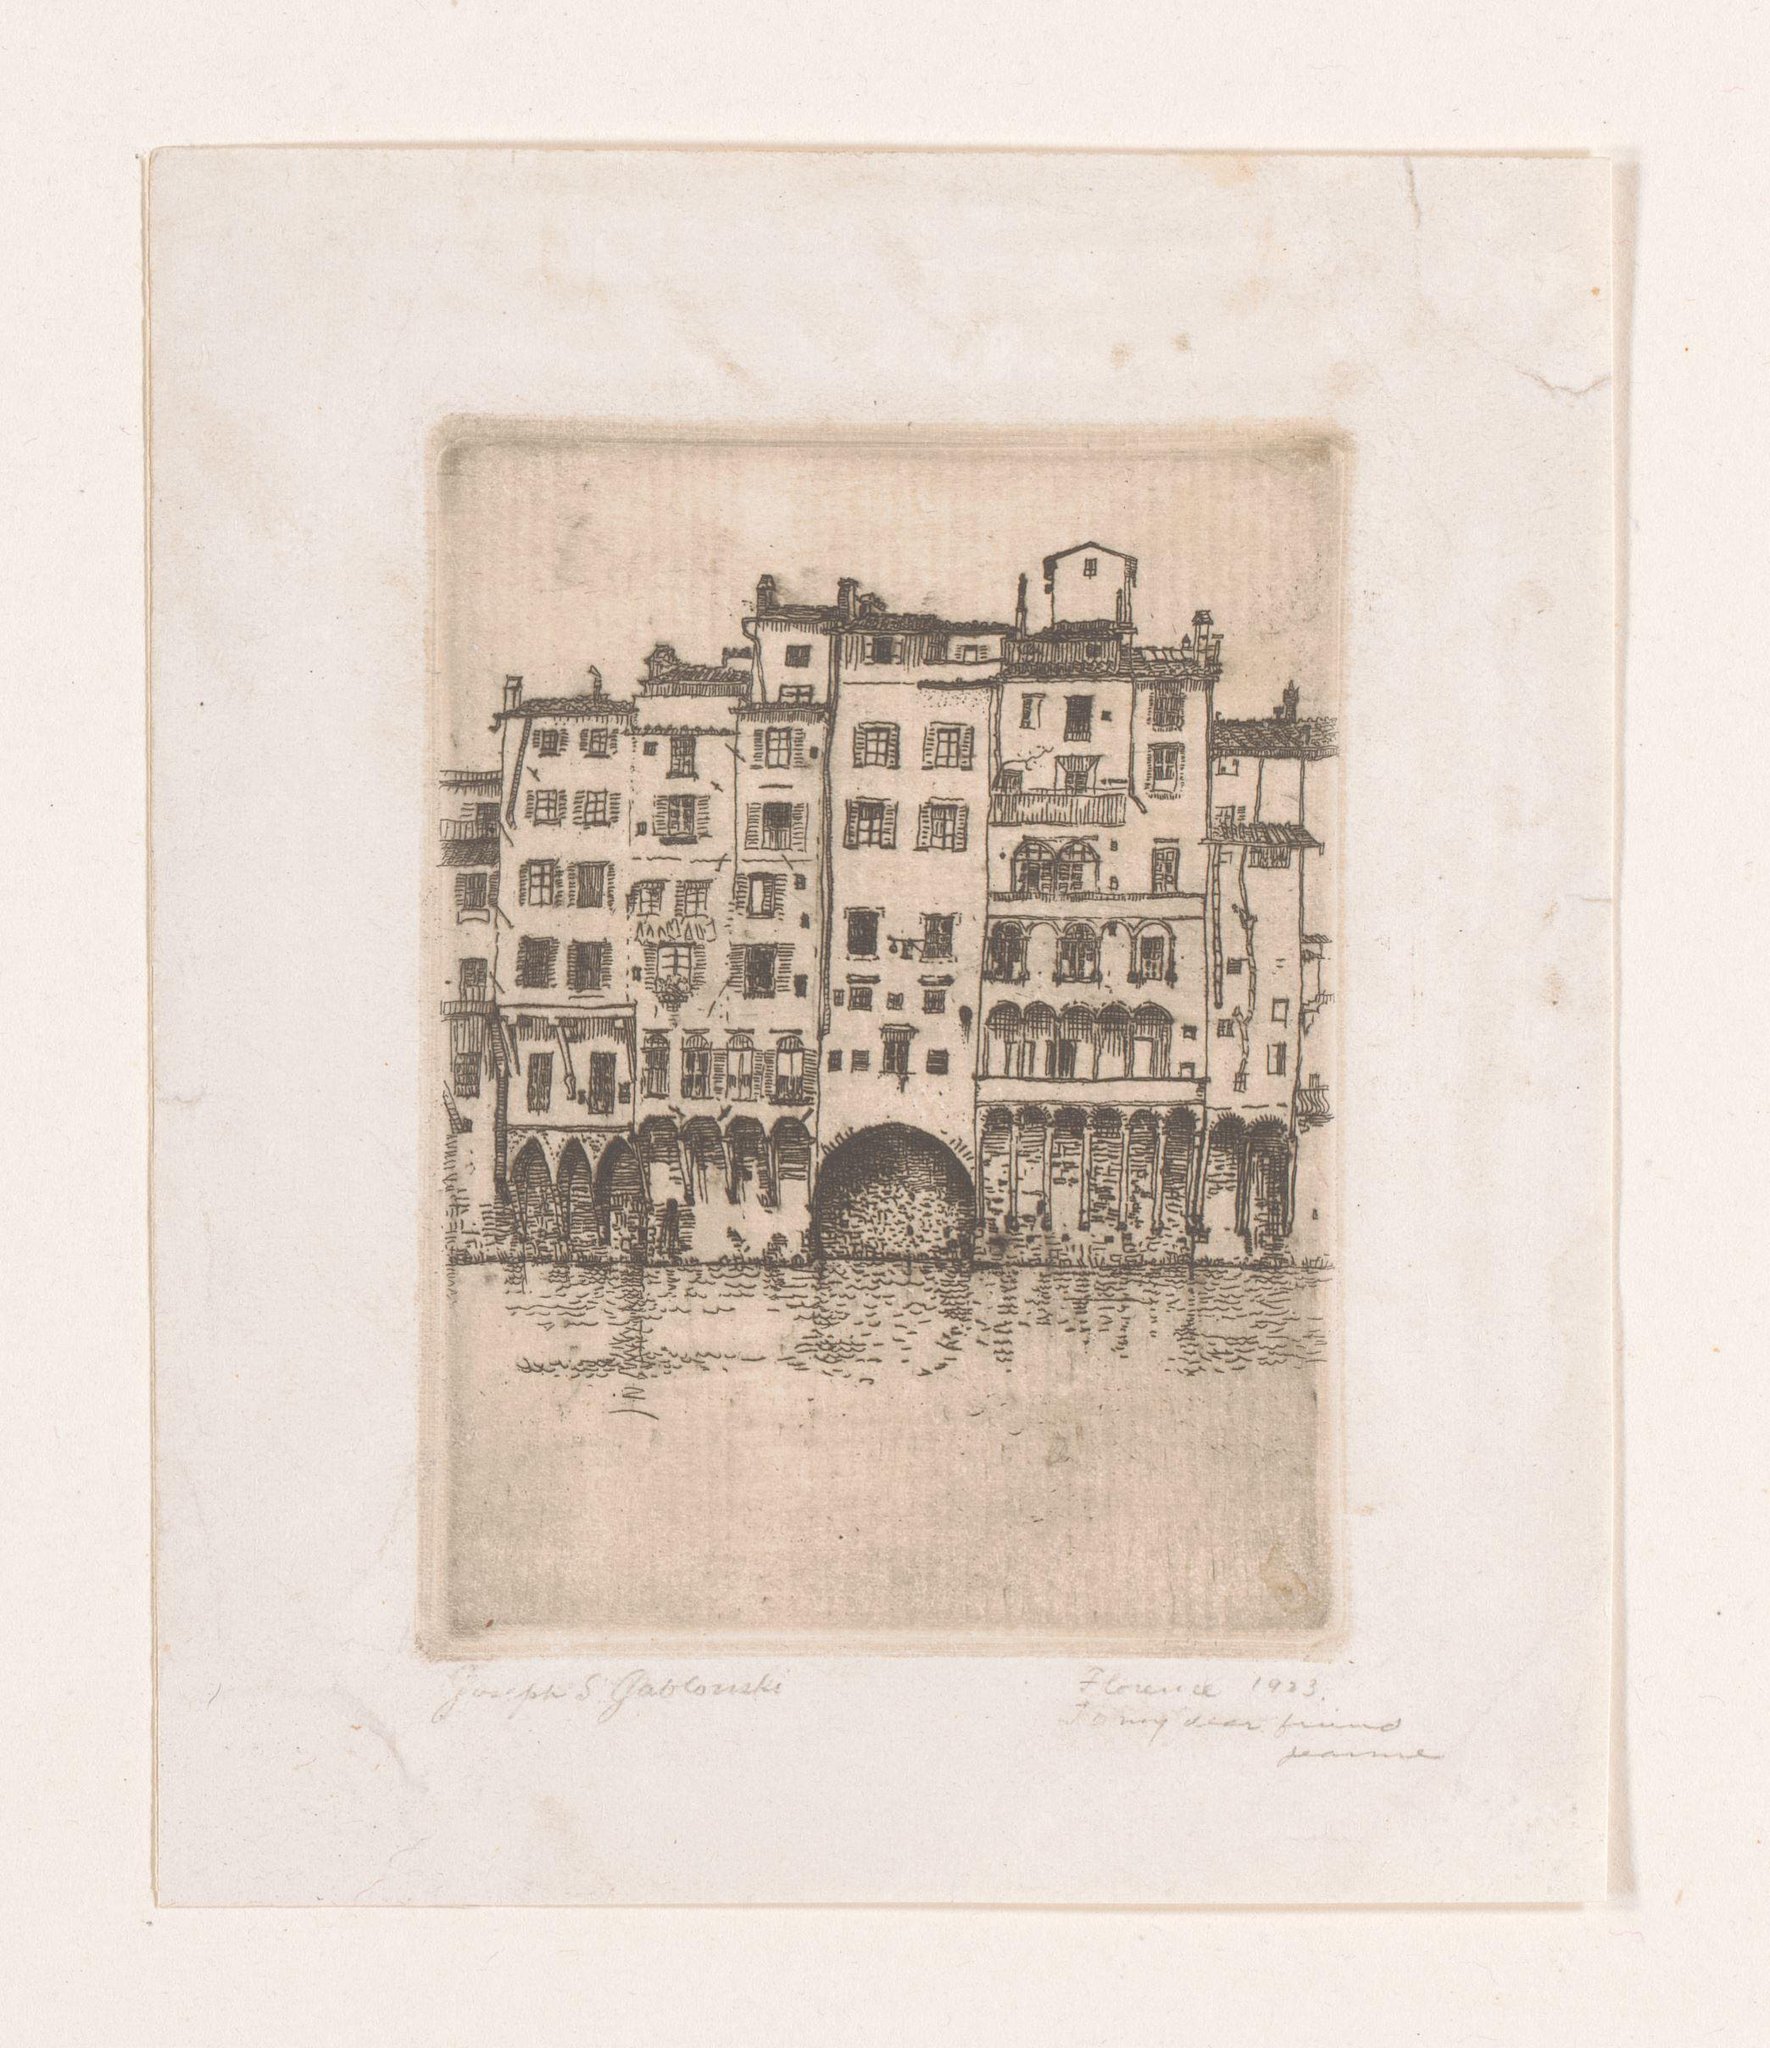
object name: print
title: Florence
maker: joseph s. gablonski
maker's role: print maker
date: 1923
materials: paper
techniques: etching, intaglio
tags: urban housing, canals, waters (in city)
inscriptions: date